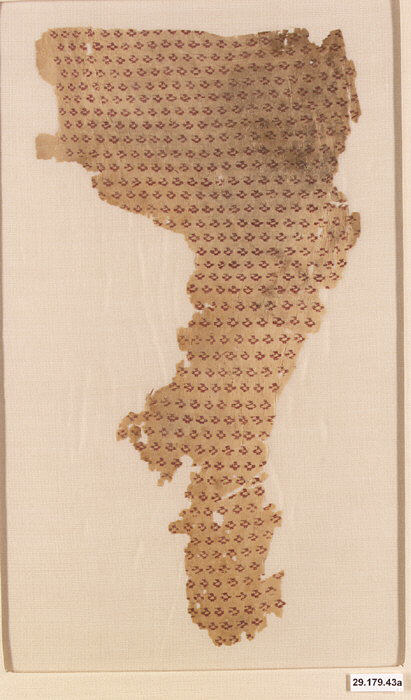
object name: textile fragment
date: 1001-1200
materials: linen, silk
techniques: brocade, weave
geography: egypt